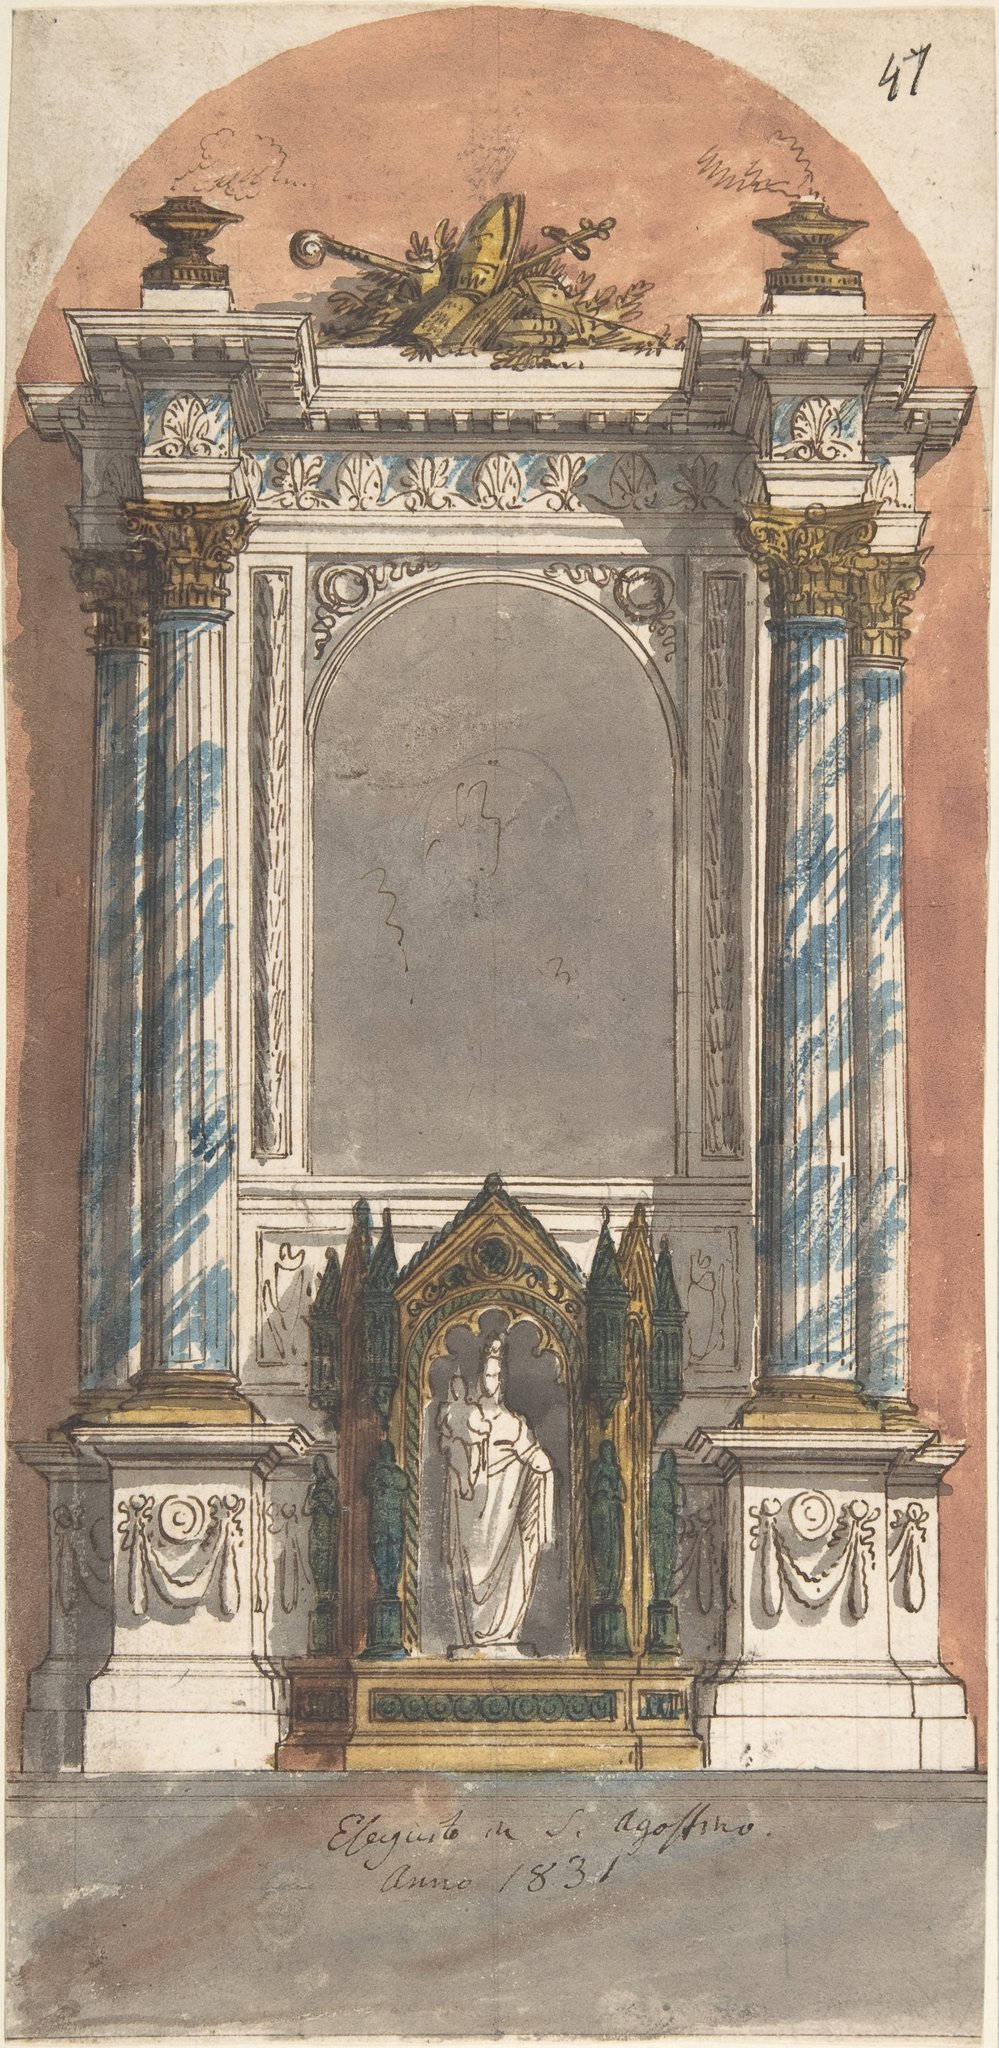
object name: drawing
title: Design for an Altar with a Statue of the Virgin and Child.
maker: anonymous, italian, 19th century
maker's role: artist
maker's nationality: italian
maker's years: 1800-1900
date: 1831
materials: graphite, ink, watercolor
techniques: pen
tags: altars,madonna and child